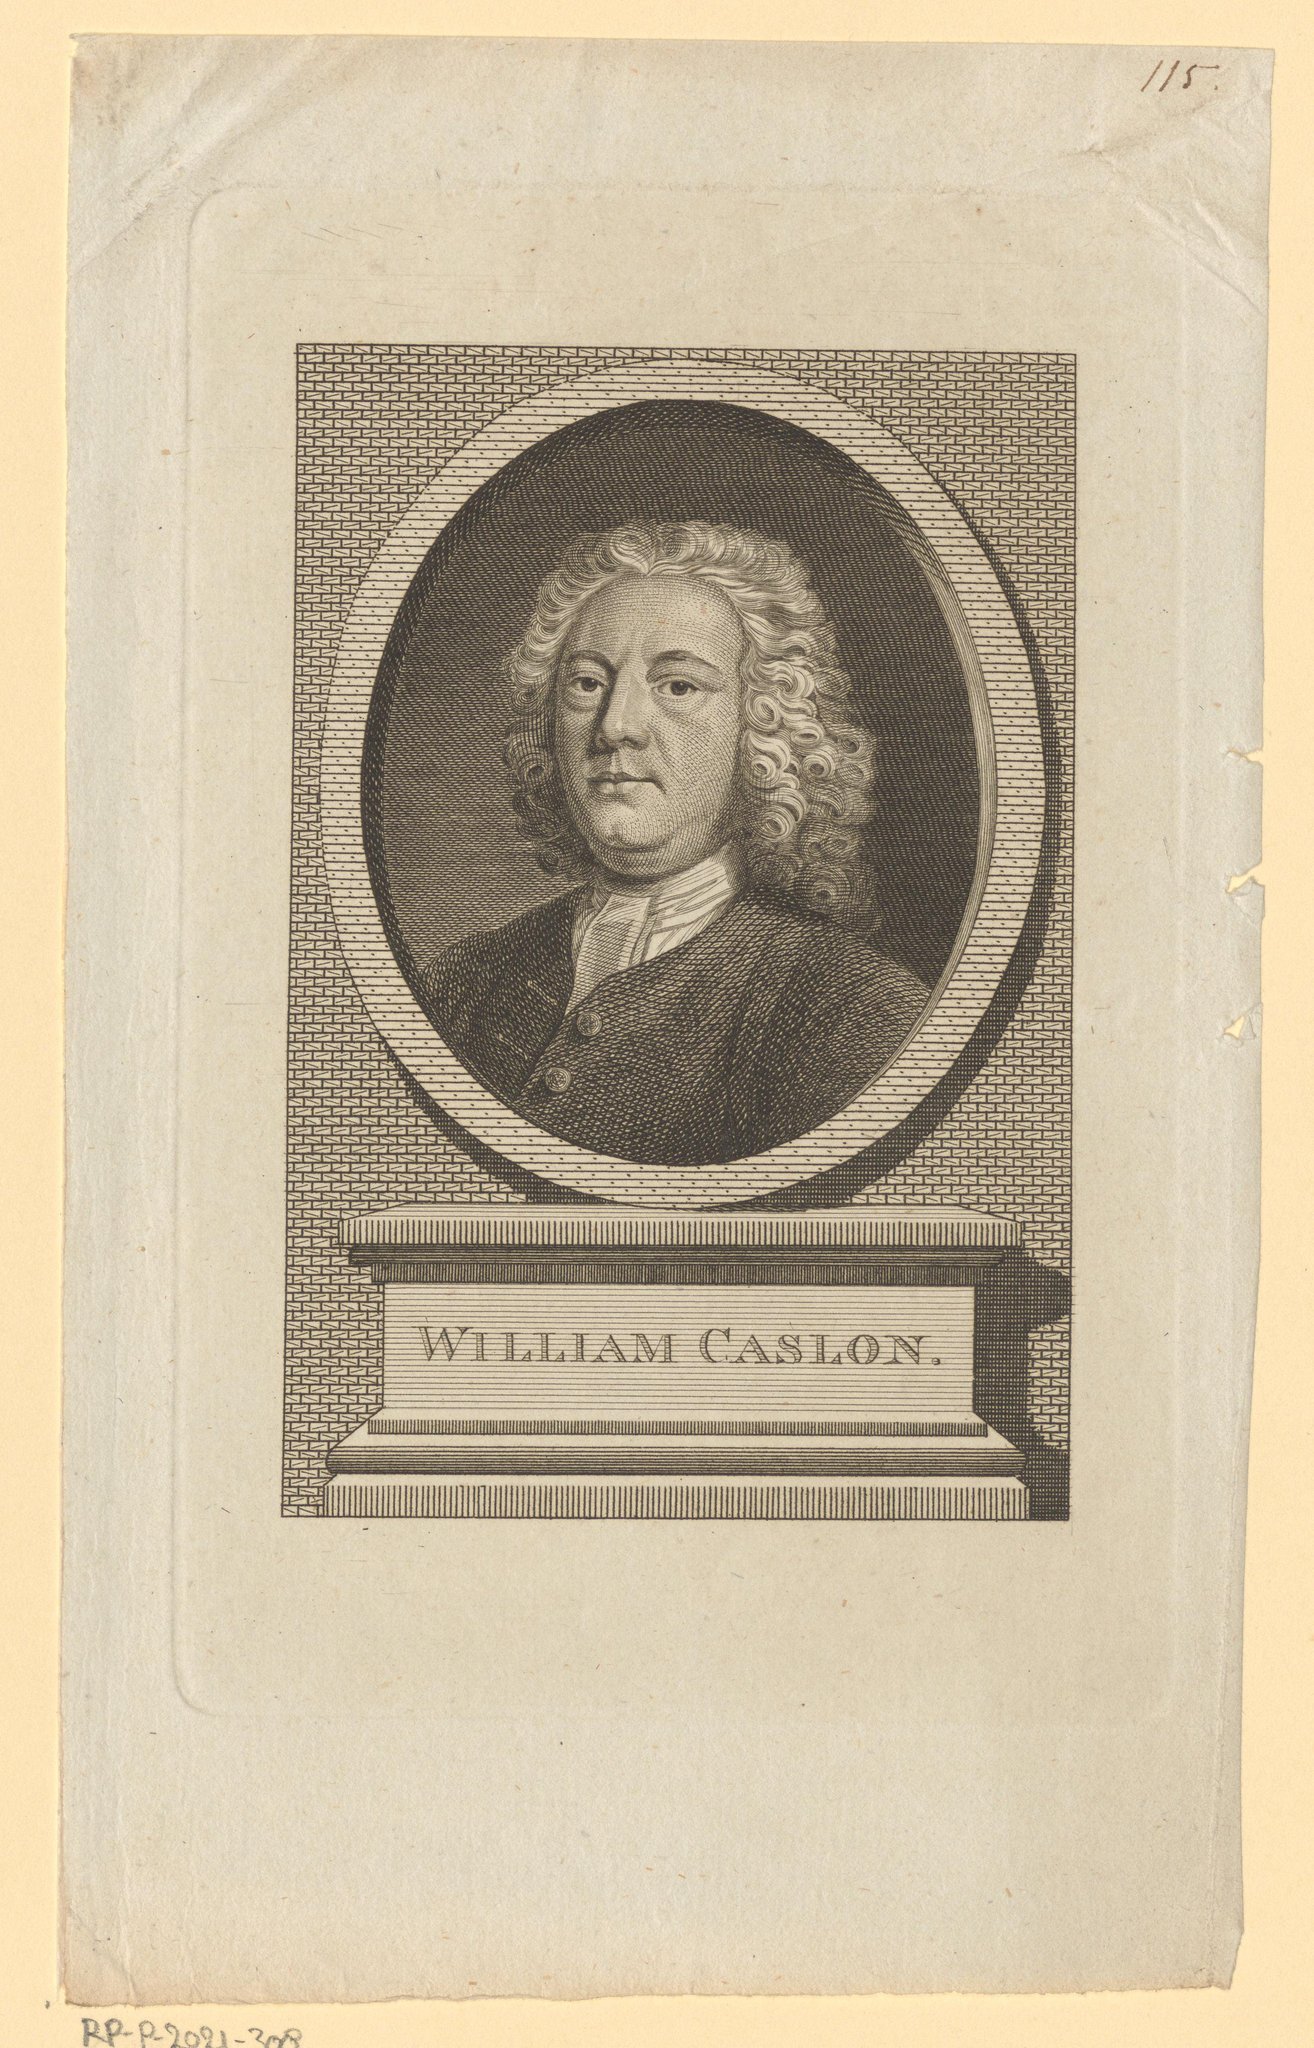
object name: print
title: Portret van William Caslon I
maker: Anonymous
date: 1716-1799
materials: paper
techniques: engraving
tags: london, printer, historical persons